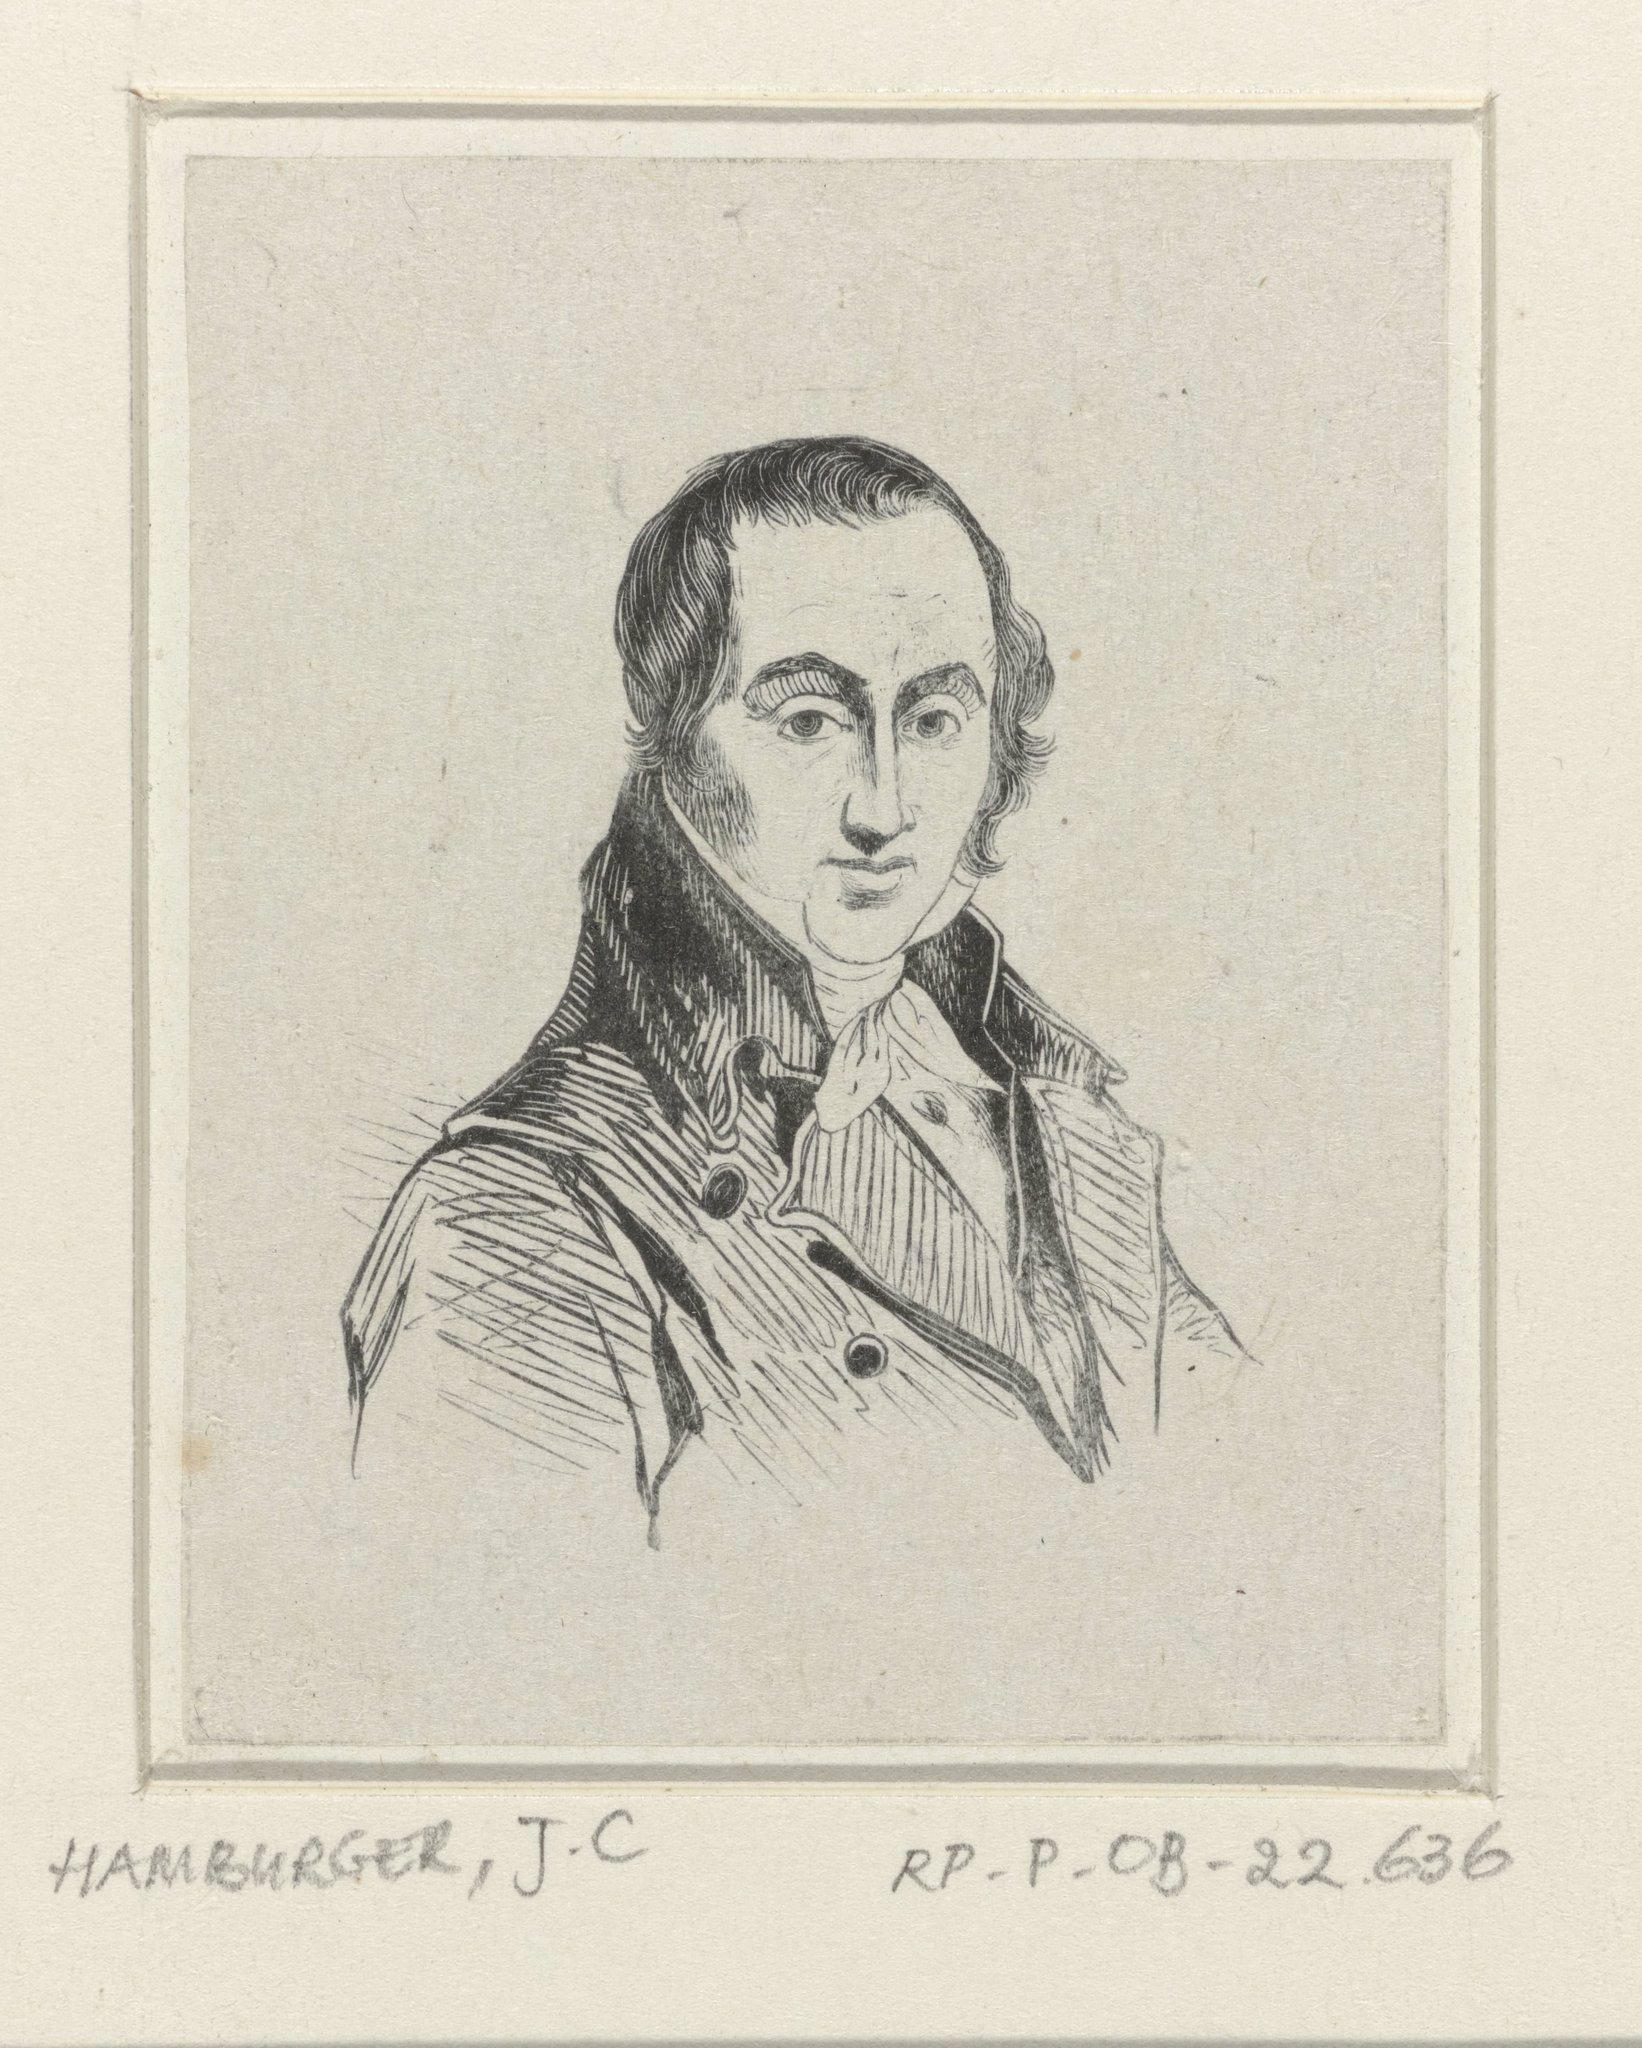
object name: print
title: Portret van Joseph Charles de Meulemeester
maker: Anonymous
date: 1819-1921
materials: paper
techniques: engraving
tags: antwerp, jozef karel de meulemeester, historical persons, portrait, self-portrait of artist